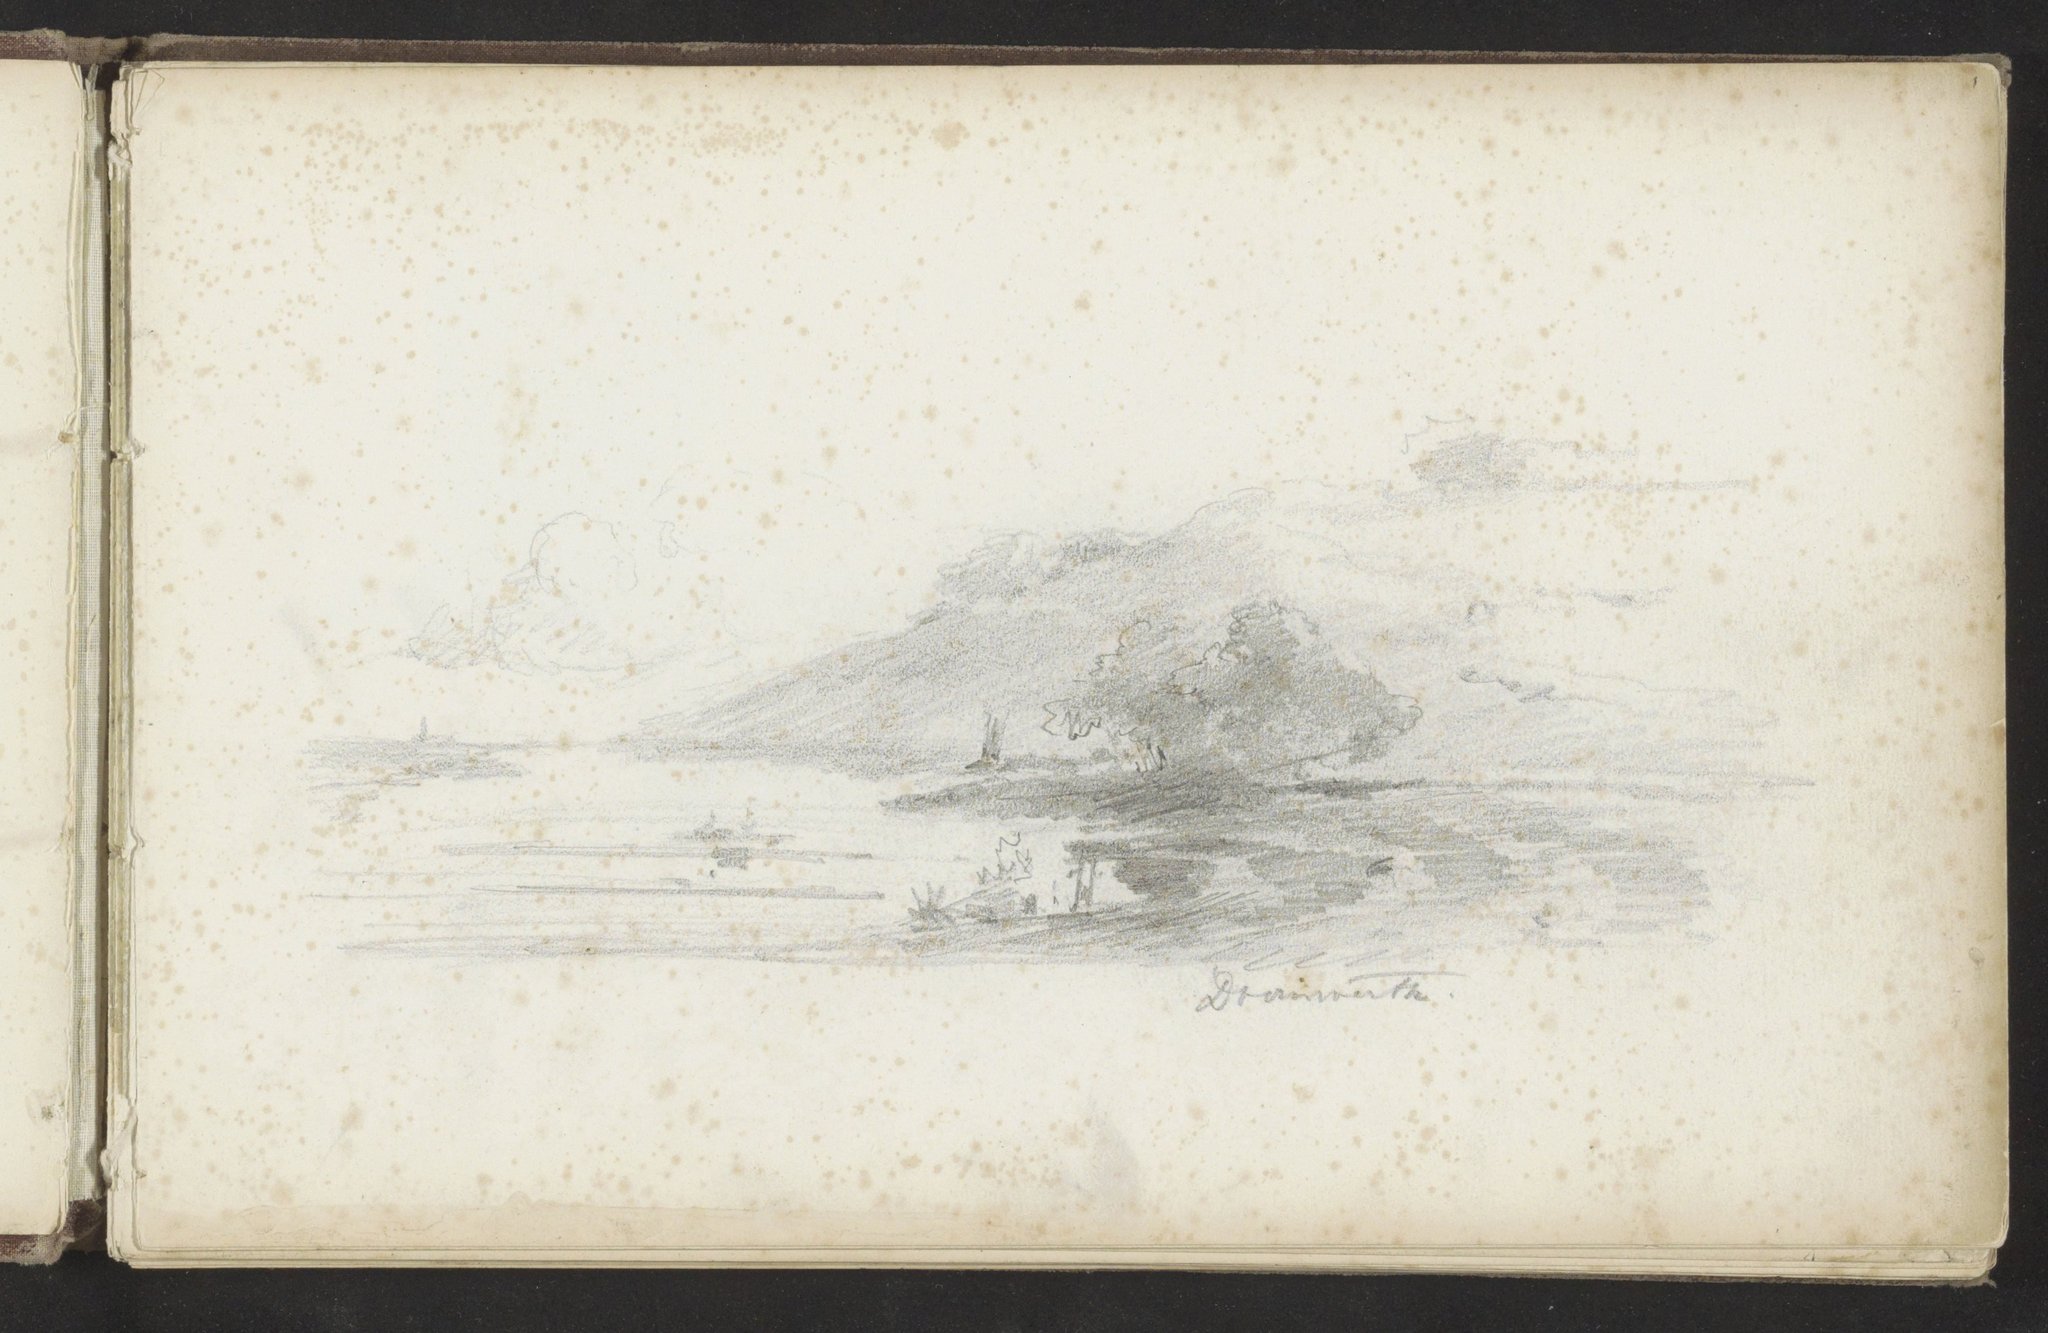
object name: sketchbook leaf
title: Doorwerth aan de Rijn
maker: maria vos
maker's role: draughtsman, painter, print maker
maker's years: 1824-1906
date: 1860-1865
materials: paper, pencil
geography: doorwerth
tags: landscapes with waters, waterscapes, seascapes (in the temperate zone)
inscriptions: annotation: ‘Doorwerth’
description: Blad 1 recto uit een schetsboek met 55 bladen.